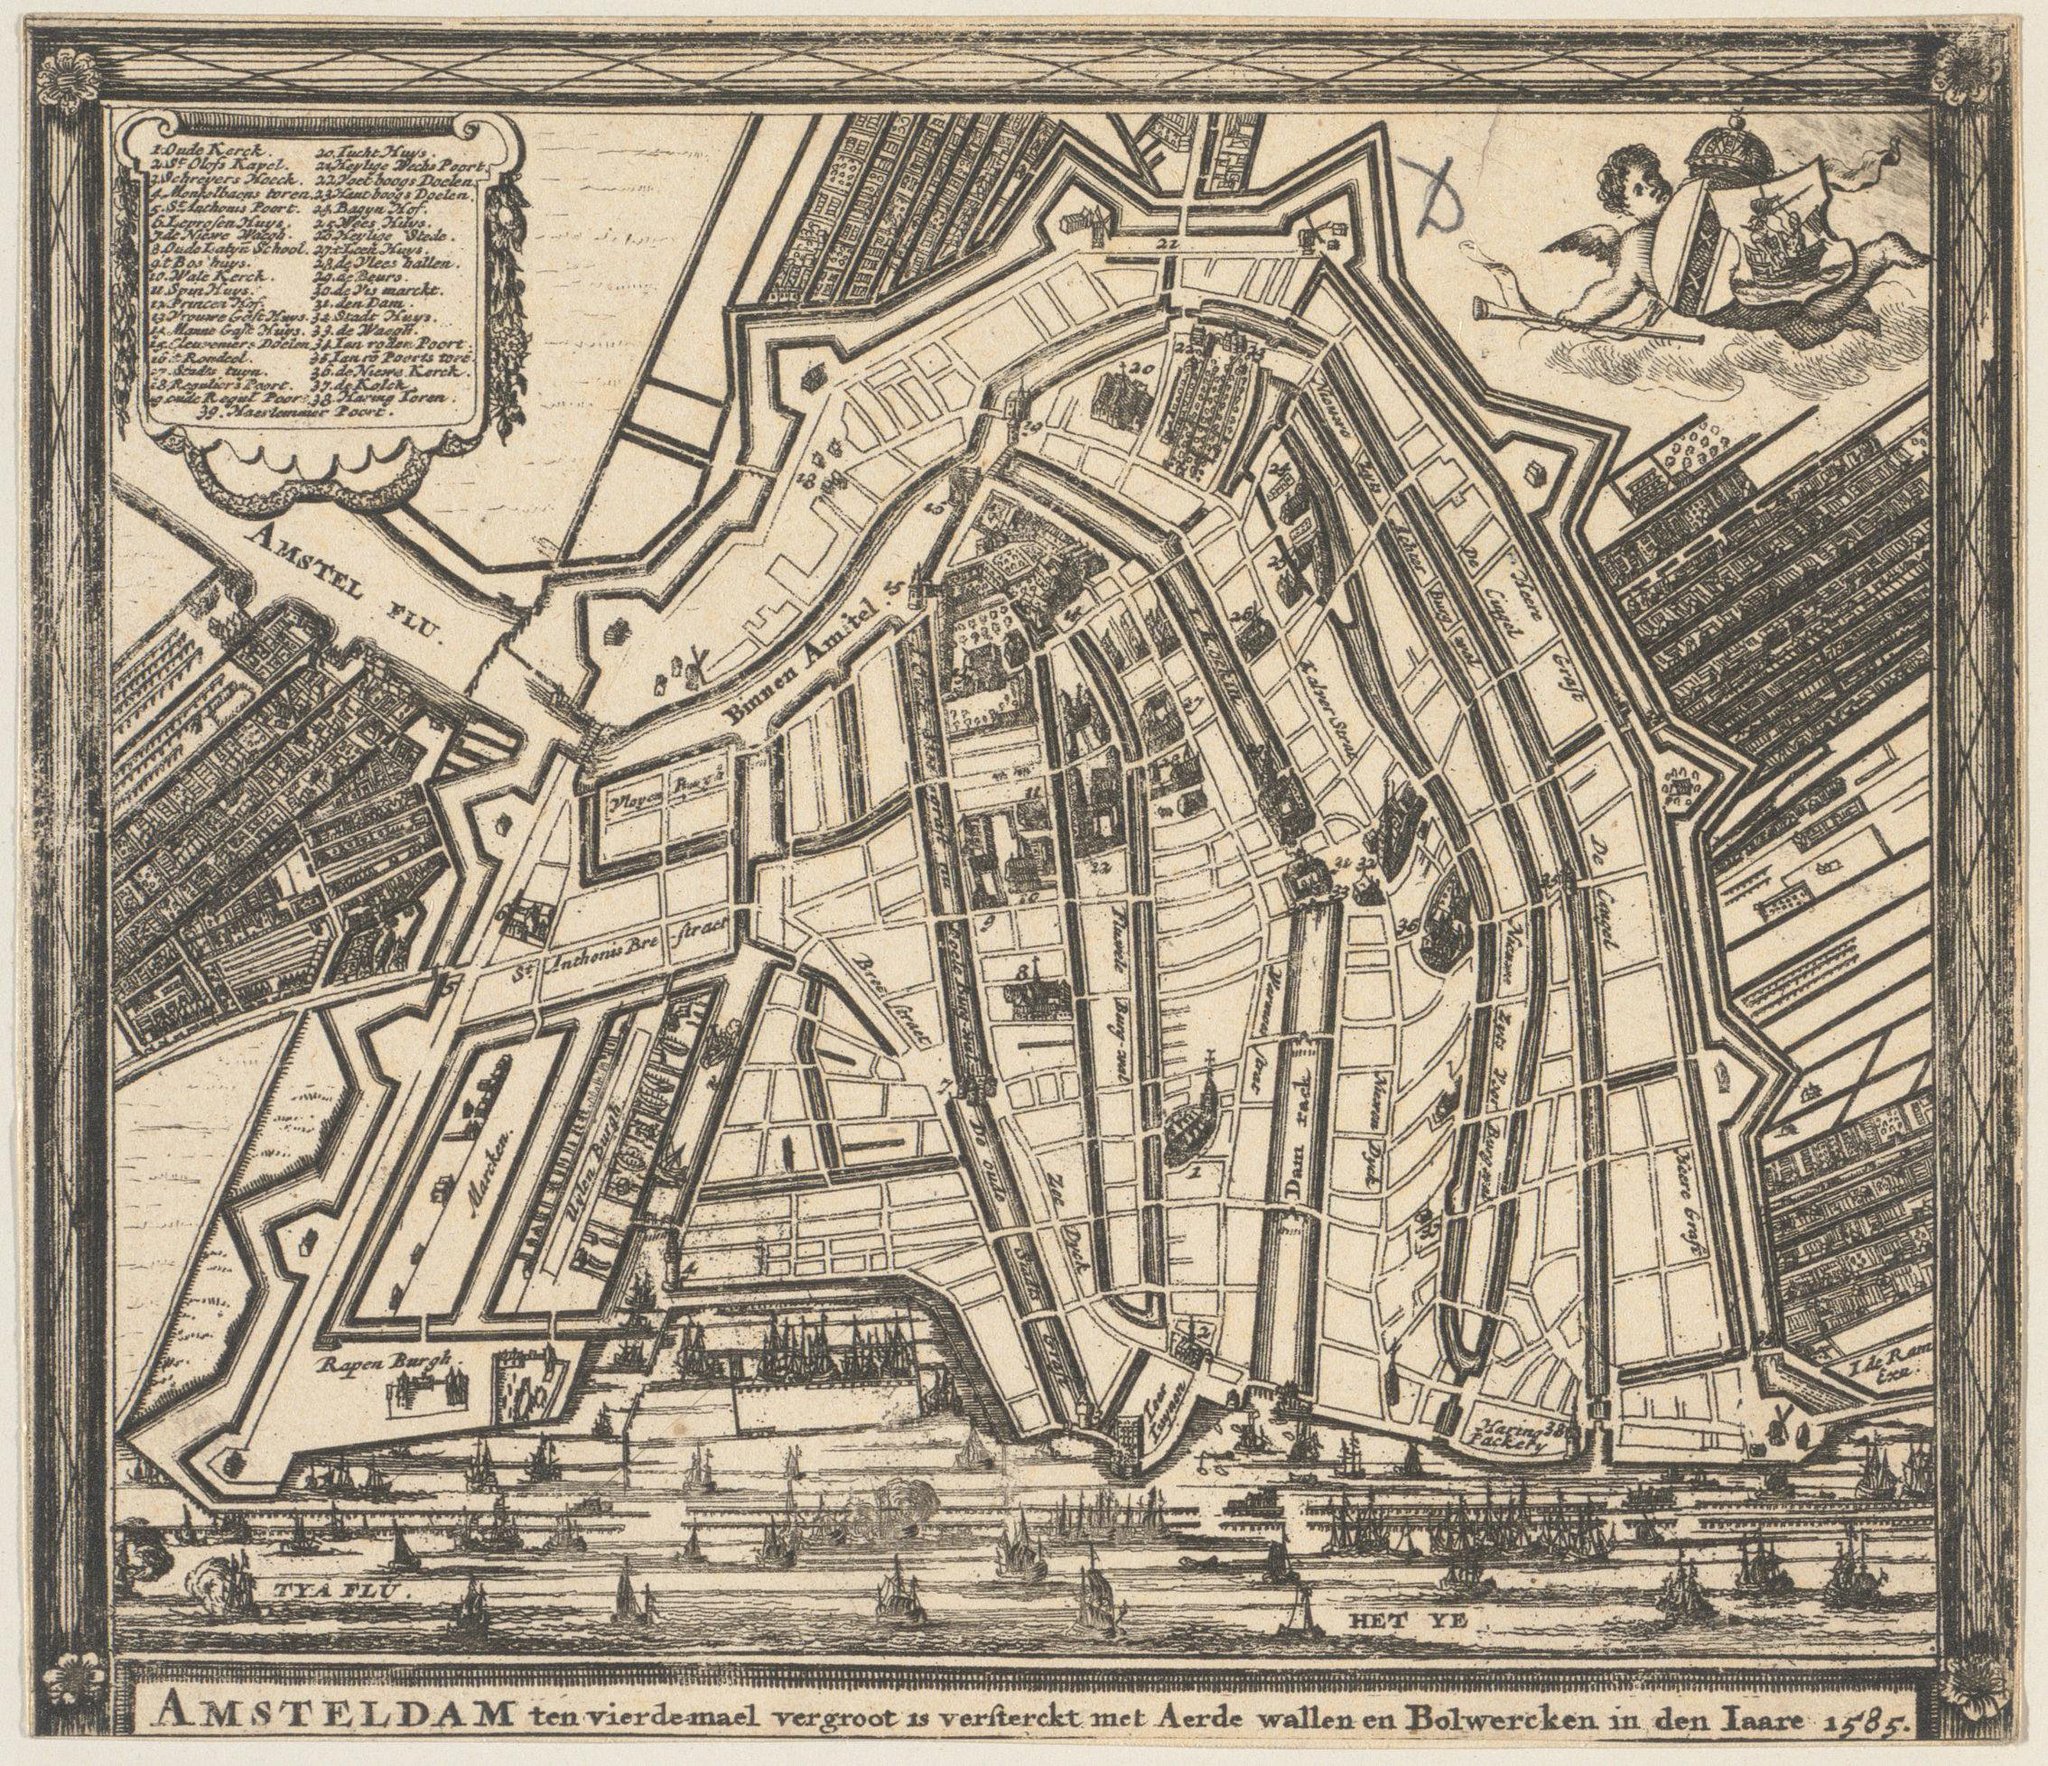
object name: area plan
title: Amsteldam ten vierde-mael vergroot is versterckt met Aerde wallen en Bolwercken in den Iaare 1585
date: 1678-1680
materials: paper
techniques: engraving, etching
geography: northern netherlands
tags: coat of arms (as symbol of the state, etc.) (+ city; municipal), maps of cities, amsterdam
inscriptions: collector's mark: Lugt 1641b